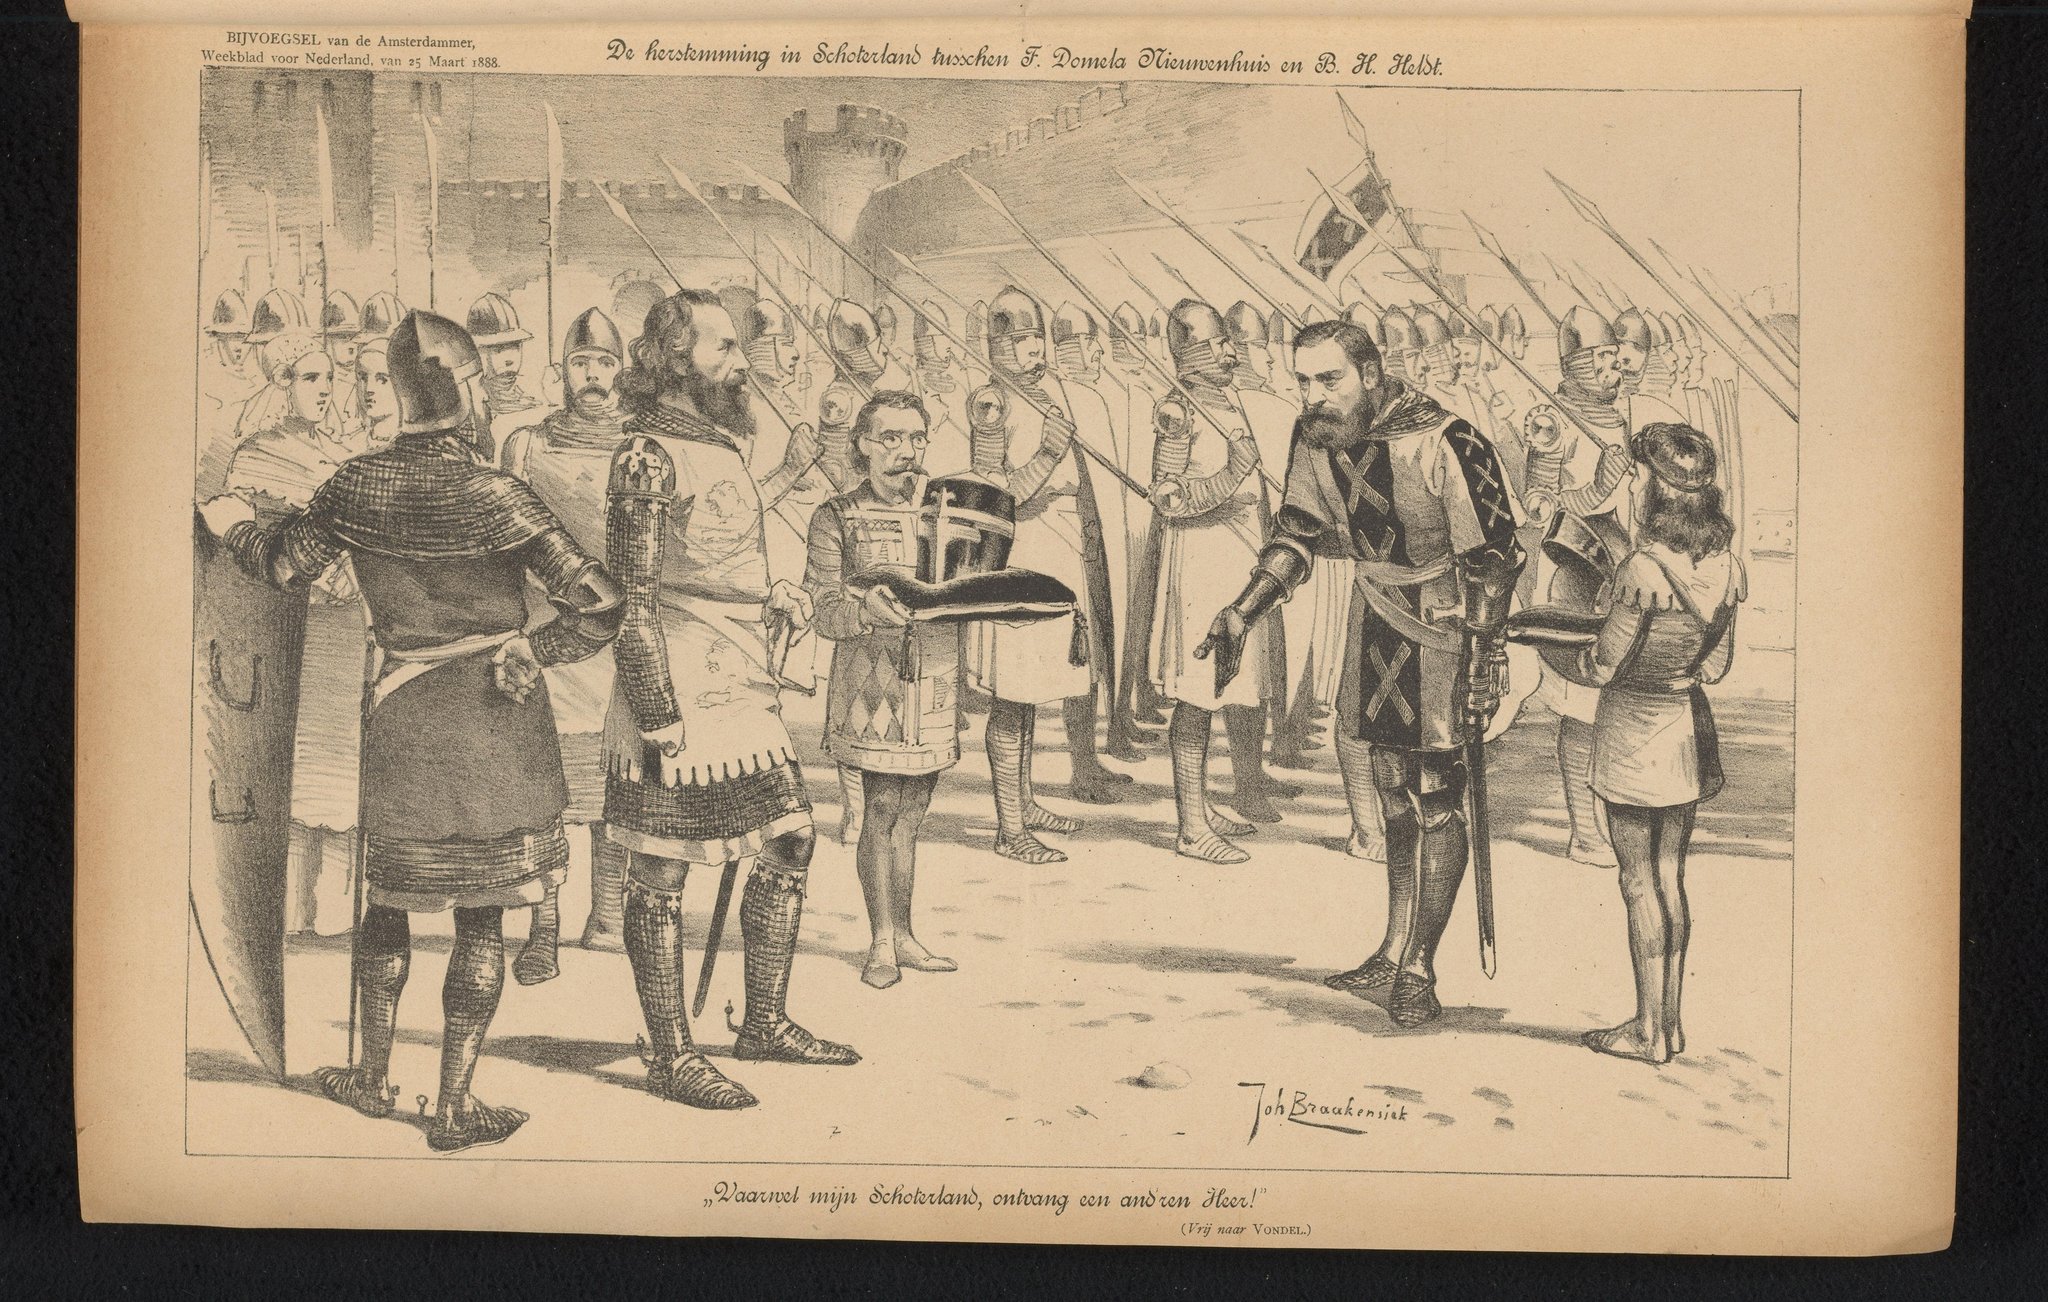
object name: cartoon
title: De herstemming in Schoterland tusschen F. Domela Nieuwenhuis en B.H. Heldt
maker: johan braakensiek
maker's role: draughtsman, print maker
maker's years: 1858-1940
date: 1888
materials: paper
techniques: lithograph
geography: amsterdam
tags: amsterdam, ferdinand domela nieuwenhuis, furniture worker, (vondel, gijsbrecht van aemstel) specific works of literature (with author, title), political caricatures and satires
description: De herstemming in het Friese district Schoterland tussen Ferdinand Domela Nieuwenhuis en Bernardus Heldt voorgesteld als het ridderlijk afscheid van Gijsbrecht, een scène uit Vondels Gijsbrecht van Amstel. Tussen de twee ridders staat de socialist Jan Antoon Fortuyn.